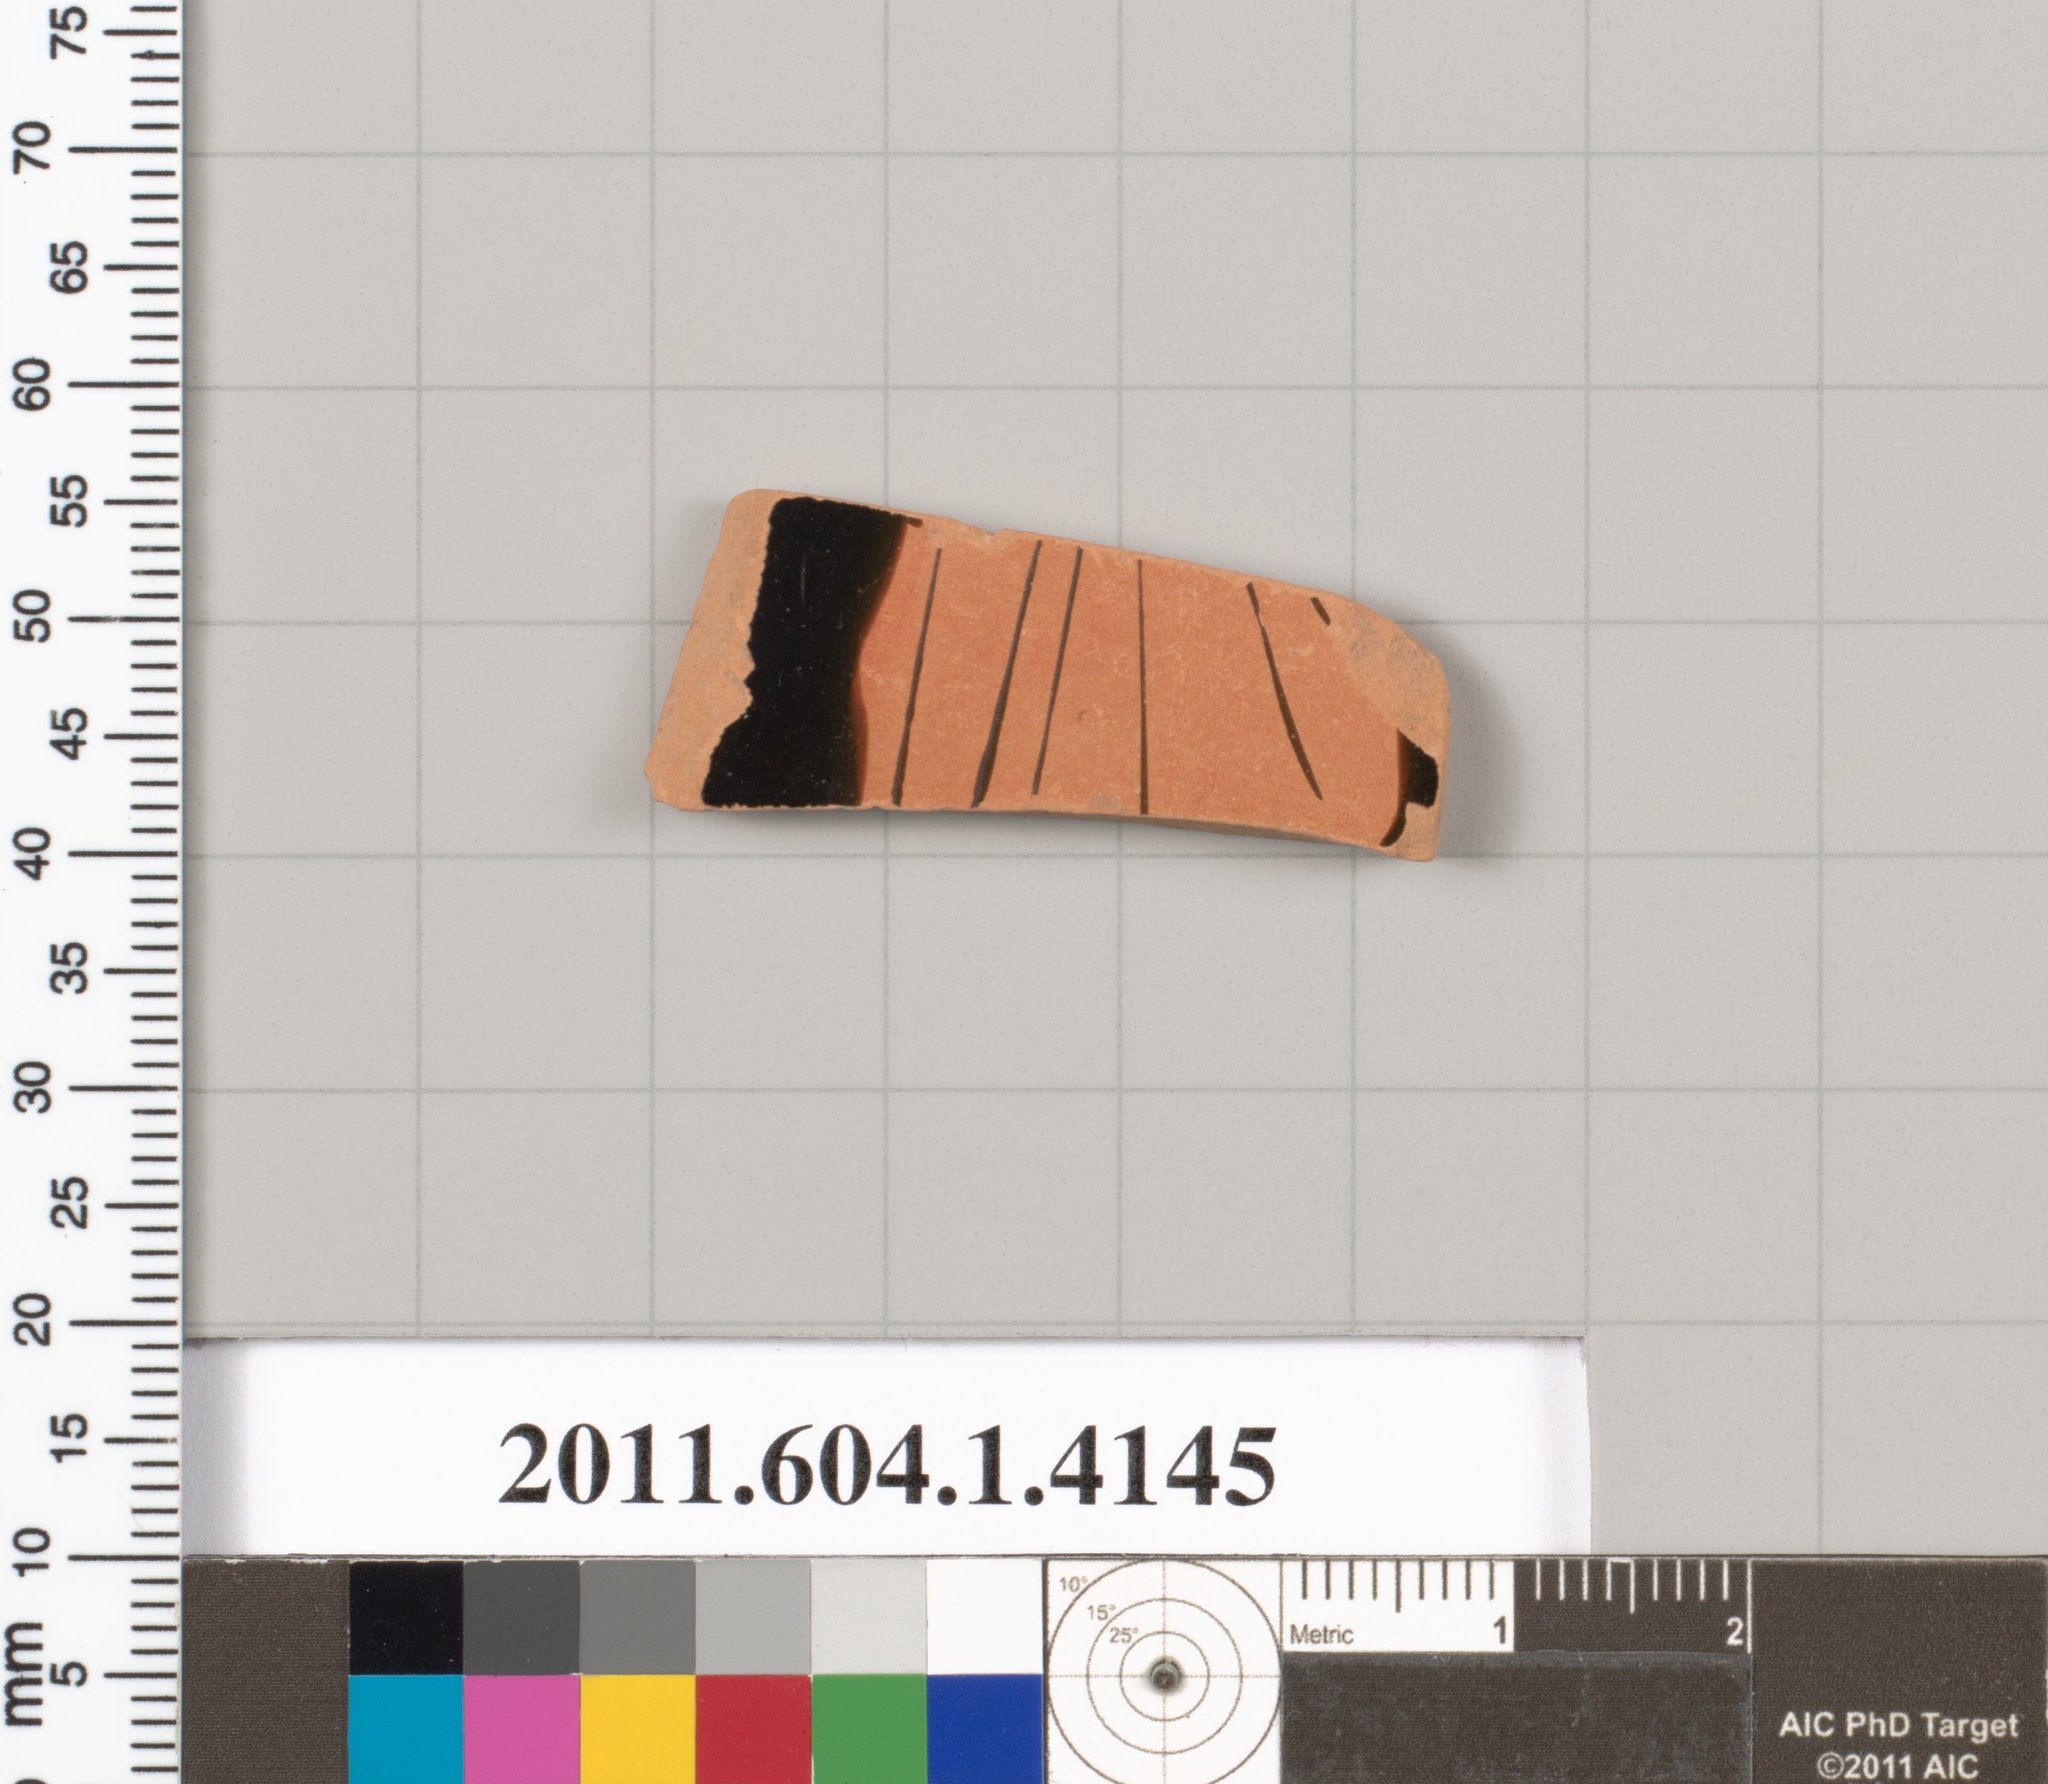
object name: kylix fragment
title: Terracotta fragment of a kylix (drinking cup)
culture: greek, attic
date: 475-451 BCE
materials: terracotta